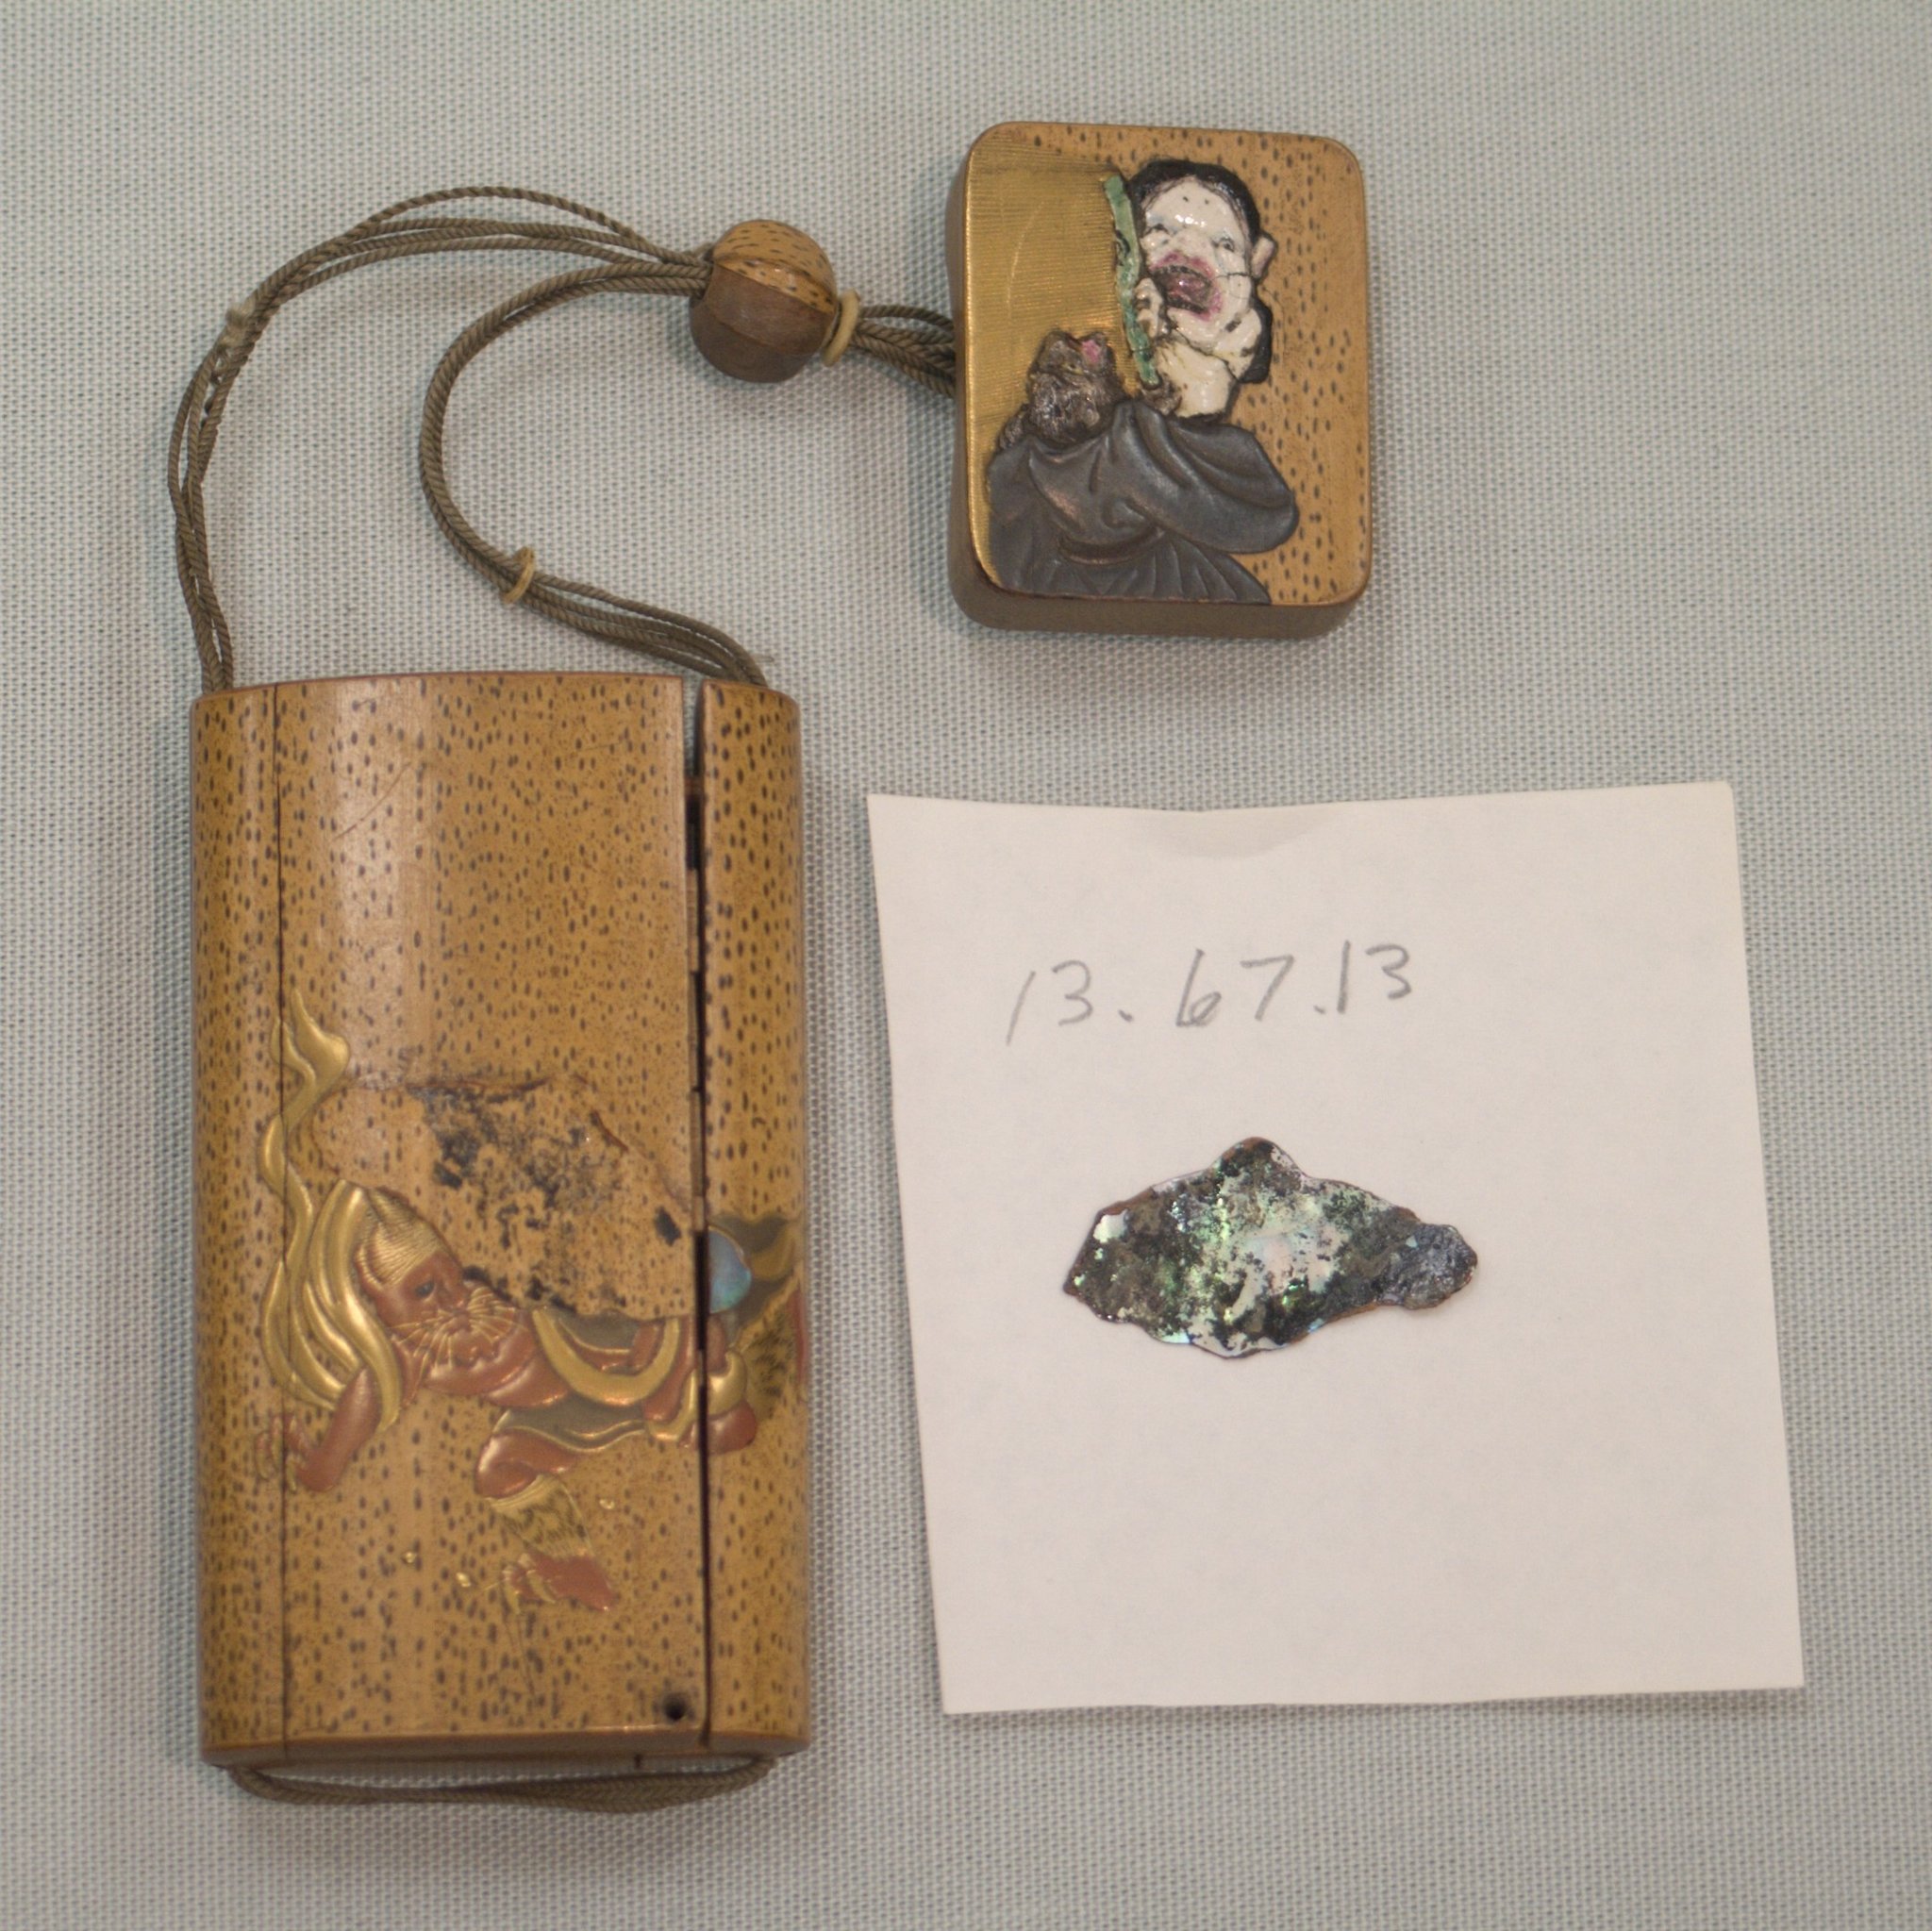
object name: inrō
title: Case (Inrō) with Design of Demon in Escape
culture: japanese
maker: shibata zeshin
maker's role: artist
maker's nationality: japanese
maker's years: 1807-1891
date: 1801-1900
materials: bamboo, gold, mother of pearl, silver, wood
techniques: hiramakie, inlay, maki-e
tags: demons